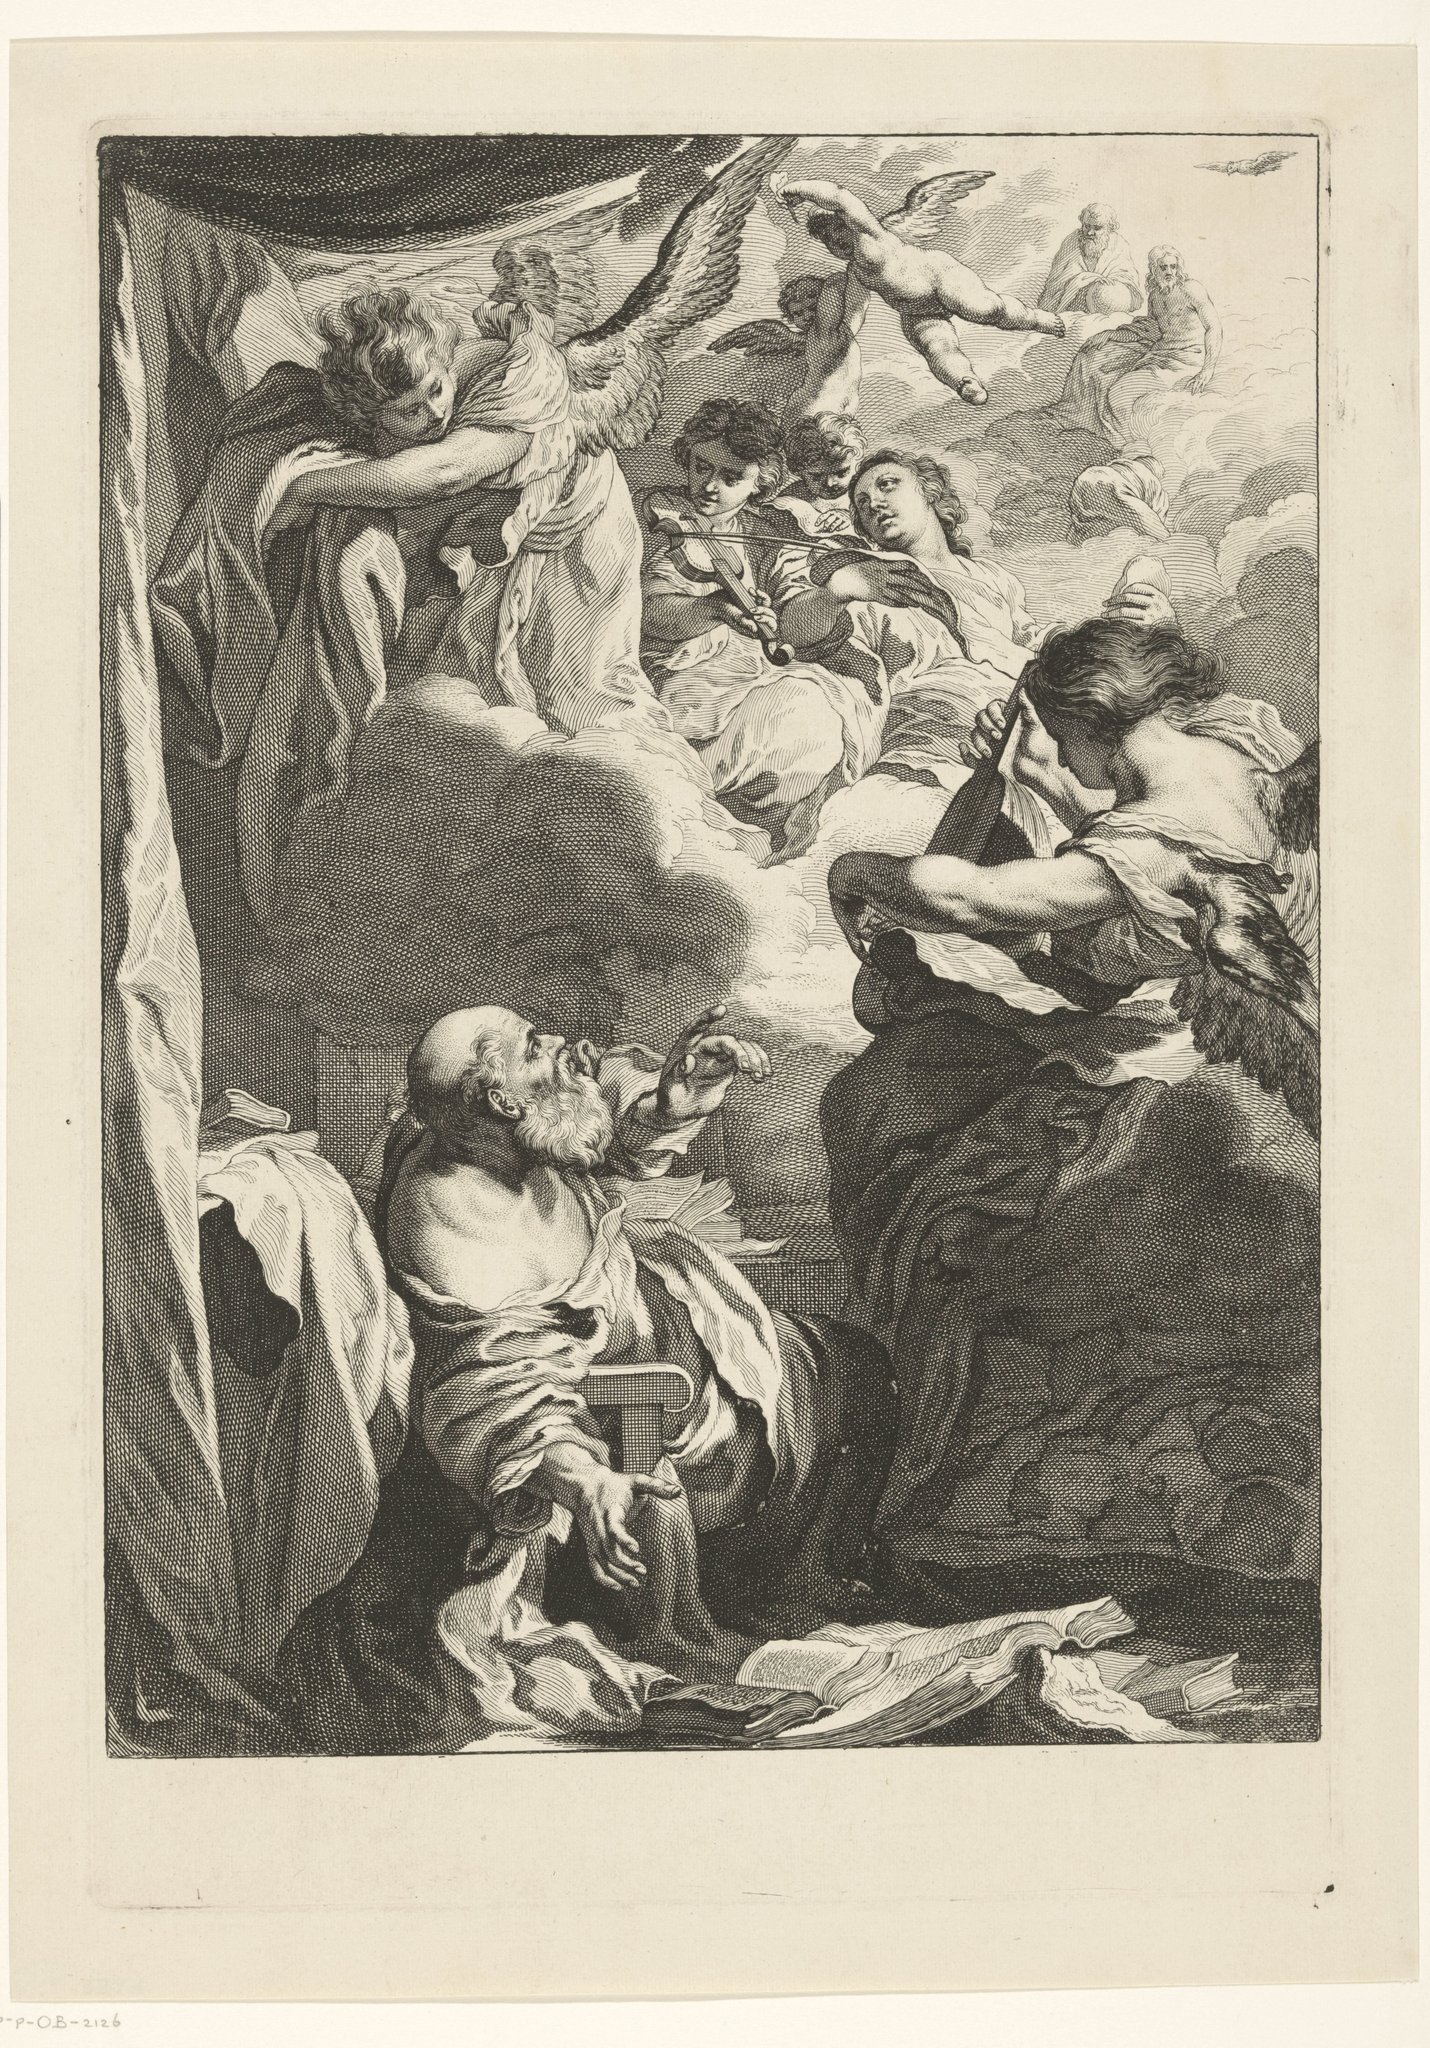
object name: print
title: Extatisch visioen van Paulus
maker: jeremias falck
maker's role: print maker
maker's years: 1609-1677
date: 1655-1677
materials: paper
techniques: engraving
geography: italy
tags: other scenes ~ acts and journeys of paul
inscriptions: collector's mark: Lugt 2165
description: Paulus zit in een kamer temidden van opengeslagen boeken en kijkt verrast op naar een hemels visioen. Een engel tilt een gordijn op een toont wolken met zingende en musicerende engelen en rechtsboven de heilige drieëenheid: God de Vader, Christus en de Heilige Geest in de gedaante van een duif.